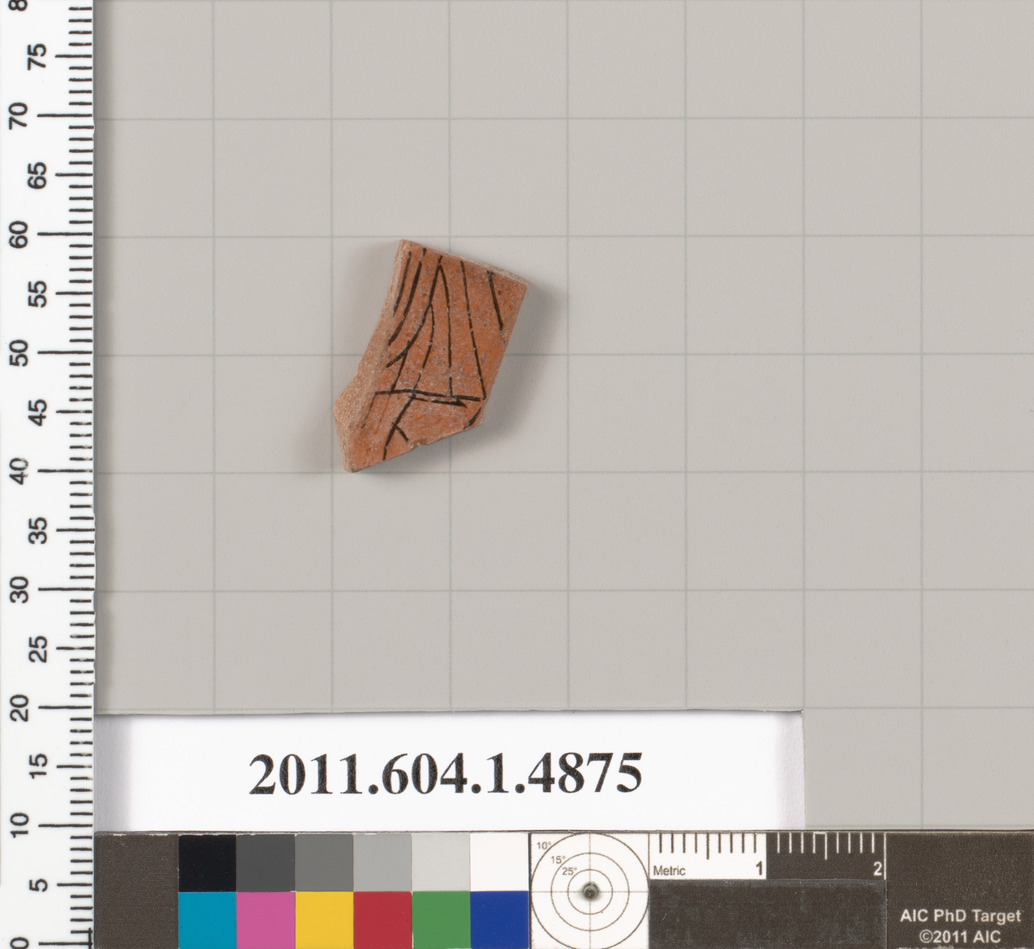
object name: kylix fragment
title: Terracotta fragment of a kylix (drinking cup)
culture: greek, attic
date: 475-451 BCE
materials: terracotta